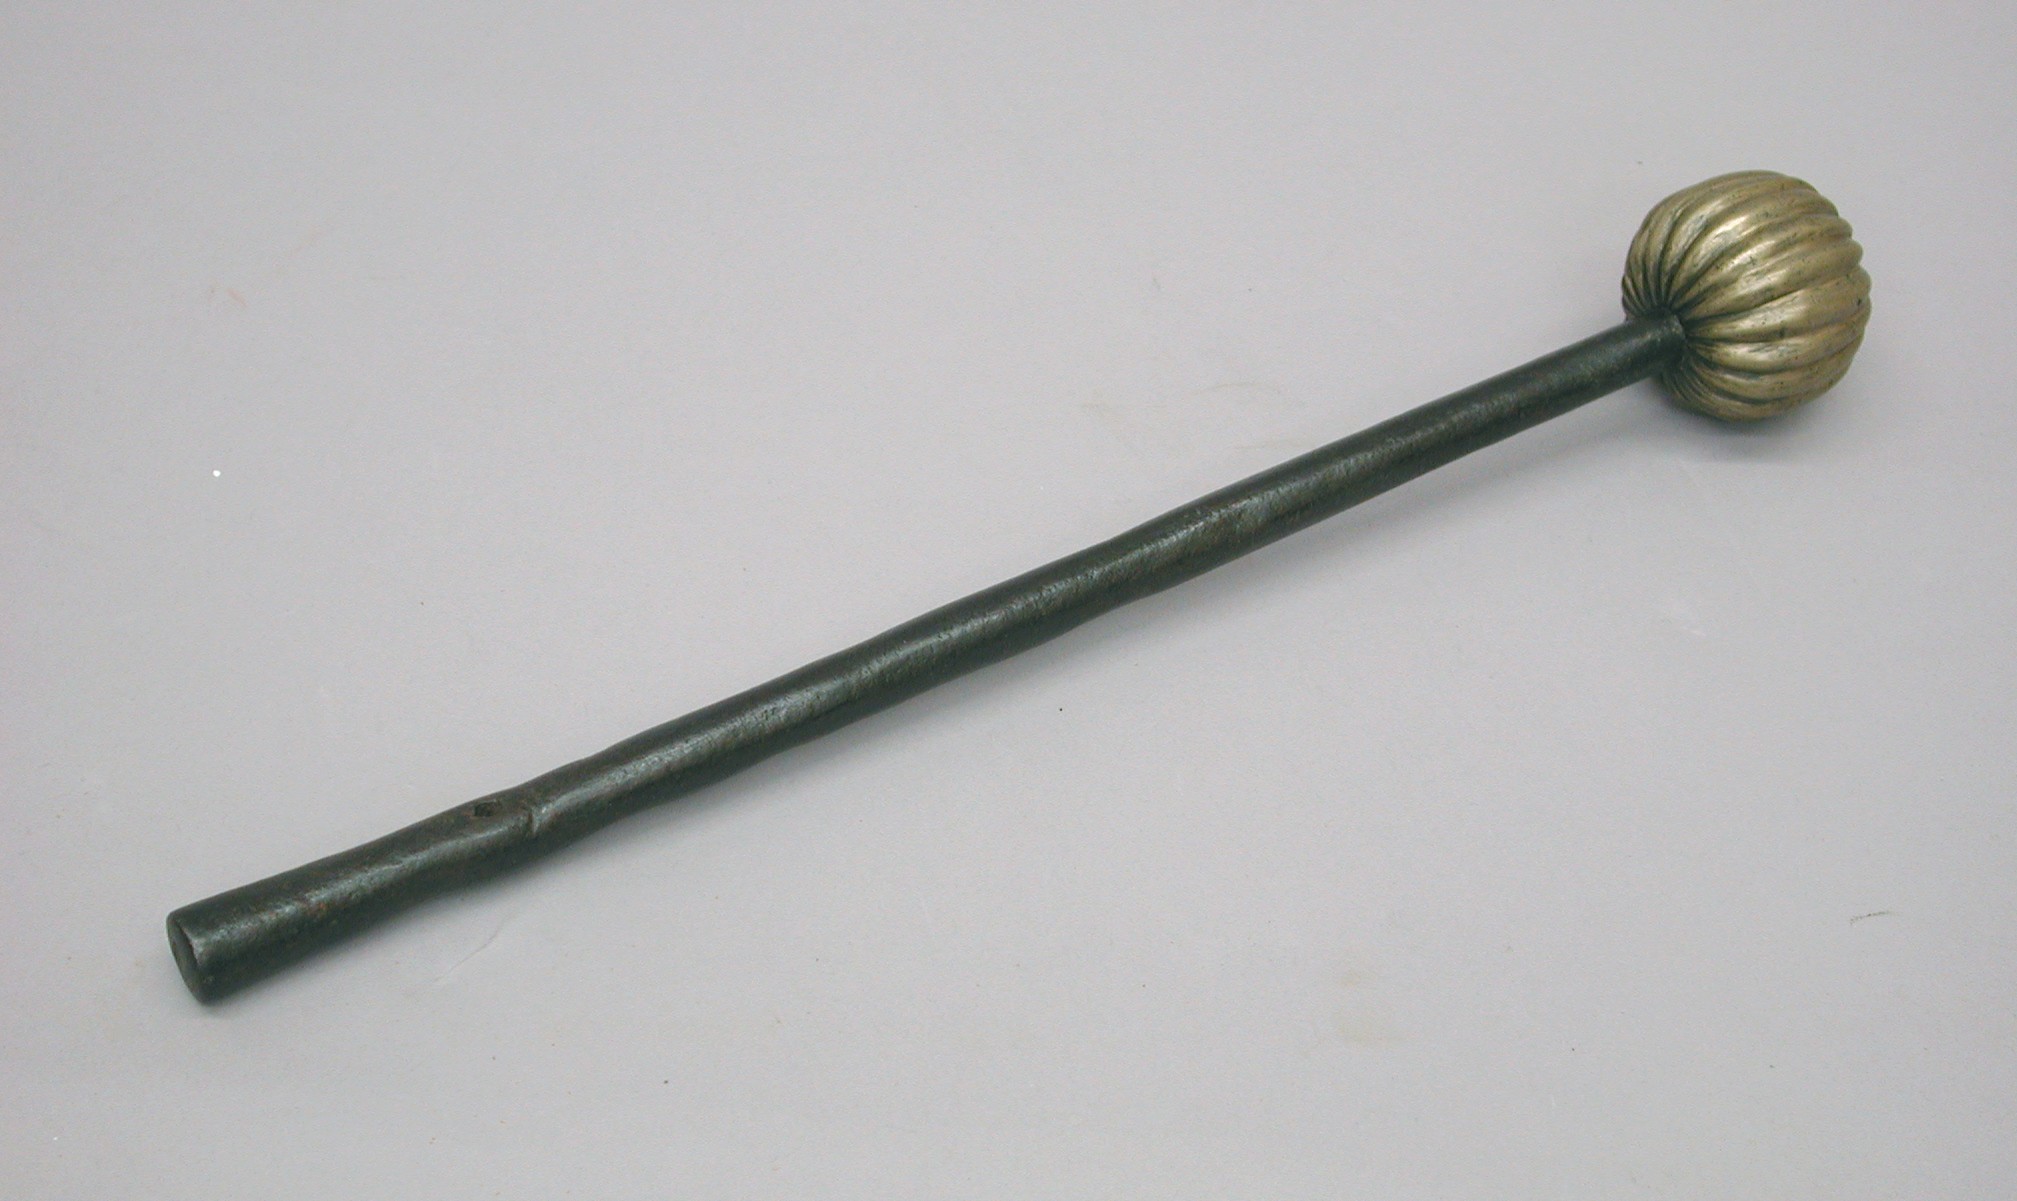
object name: mace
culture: chinese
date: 1701-1800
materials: brass, iron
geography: china